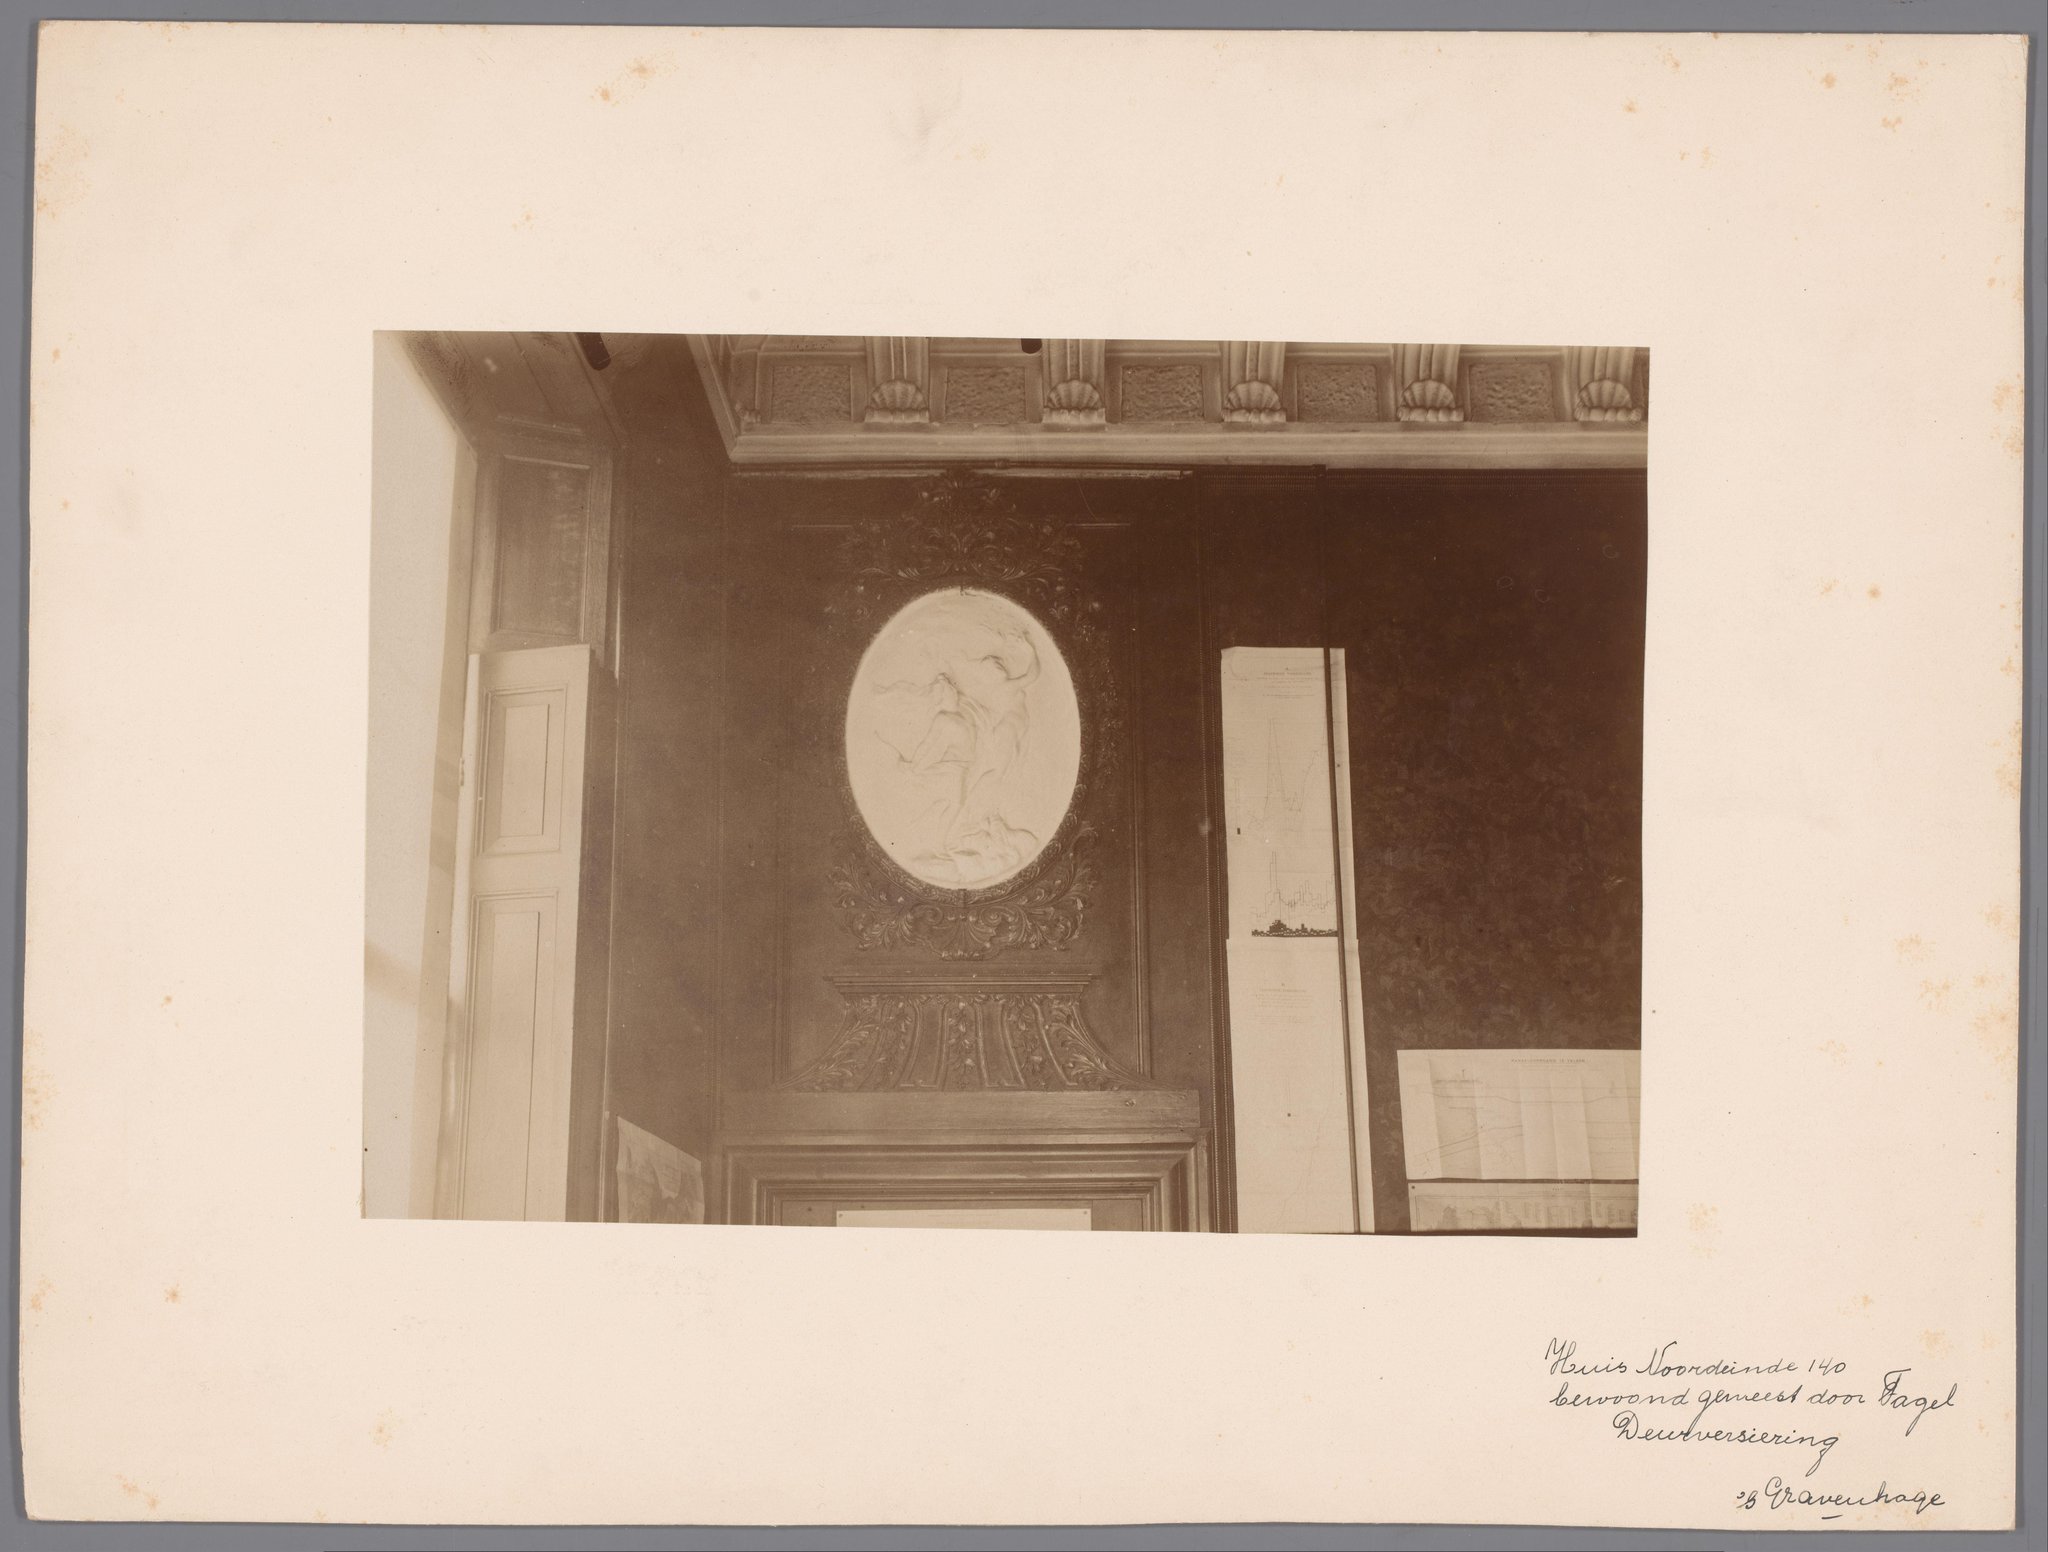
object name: photograph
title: Deurversiering in het huis op Noordeinde 140 te Den Haag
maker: anoniem (monumentenzorg)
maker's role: fotograaf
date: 1900-1915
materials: cardboard, photographic support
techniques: albumen print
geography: noordeinde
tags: door, wall-covering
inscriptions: collector's mark: ‘R:MUS.’ Lugt 2228, annotation: ‘Een deurversiering in het huis N:140 Noordeinde/ 's Gravenhage (Z.H.)’, annotation: ‘Huis Noordeinde 140/ bewoond geweest door Fagel/ Deurversiering/ 's Gravenhage’